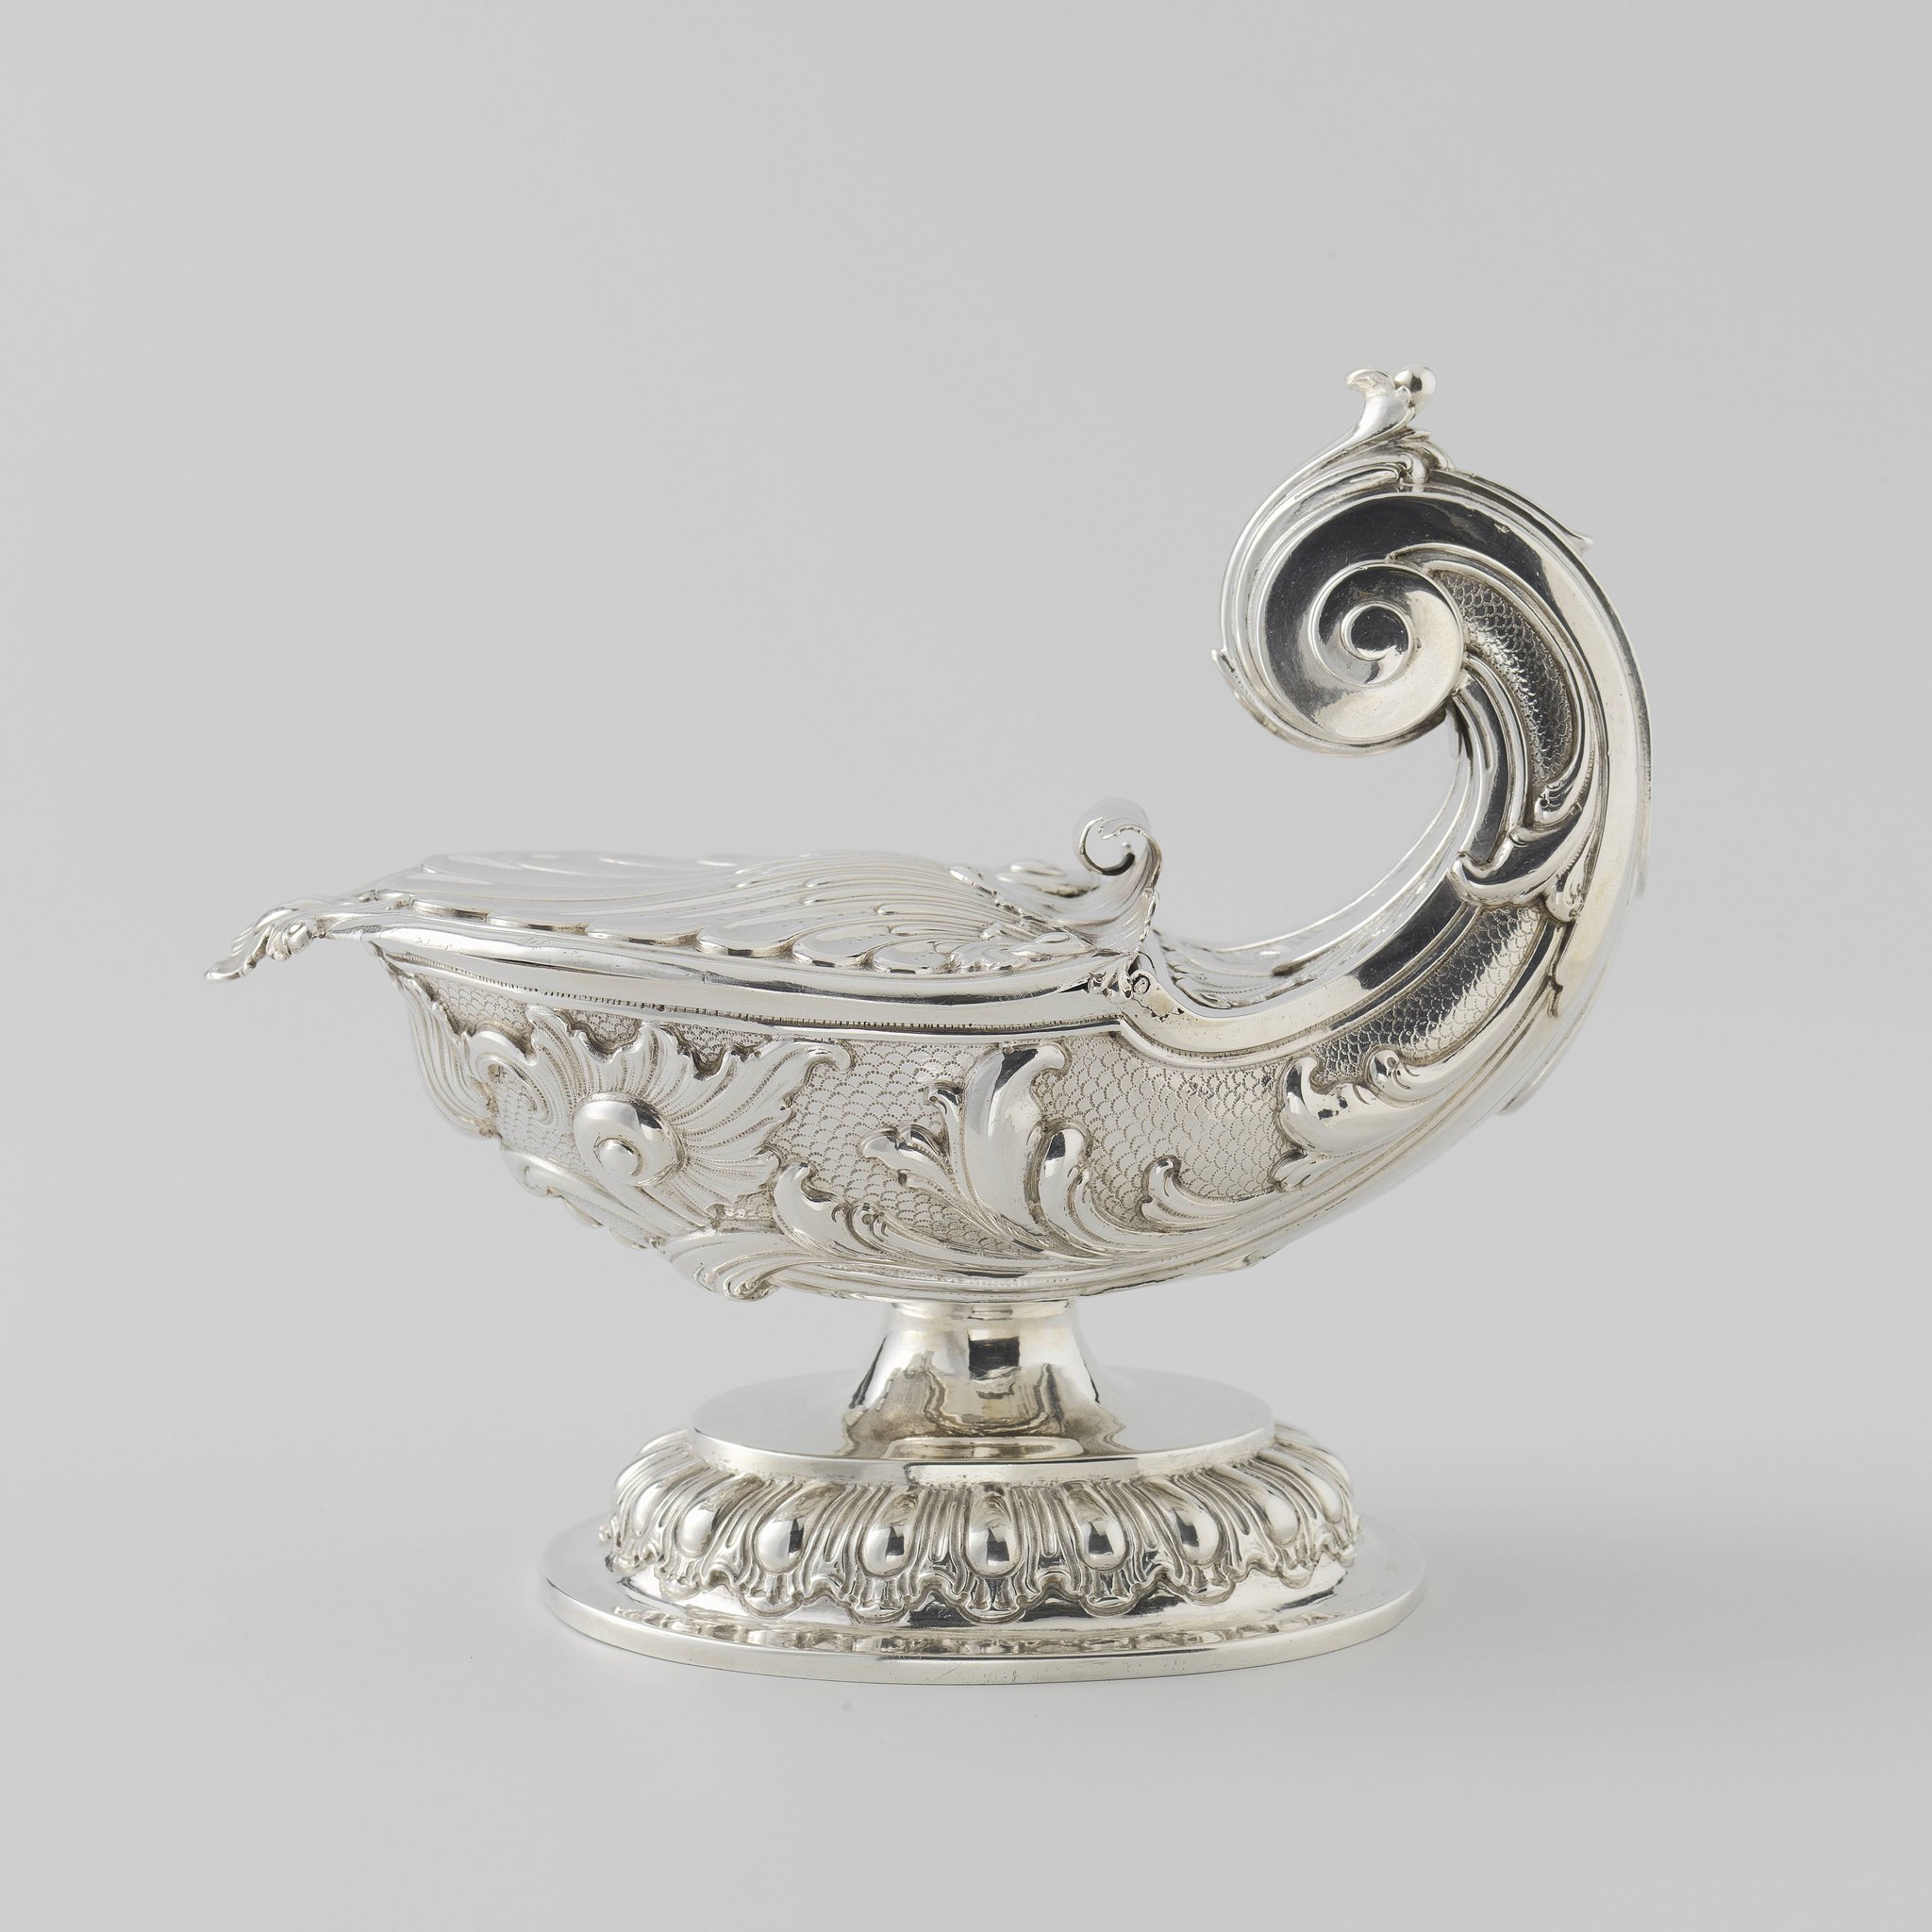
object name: incense boat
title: Wierookscheepje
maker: rabanus raab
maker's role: silversmith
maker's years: 1721-1786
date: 1740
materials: silver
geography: boxmeer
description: Incense boat. Silver. Boxmeer, c. 1740, by Rabanus Raab. Given by the Commissie voor Fotoverkoop, 1970.